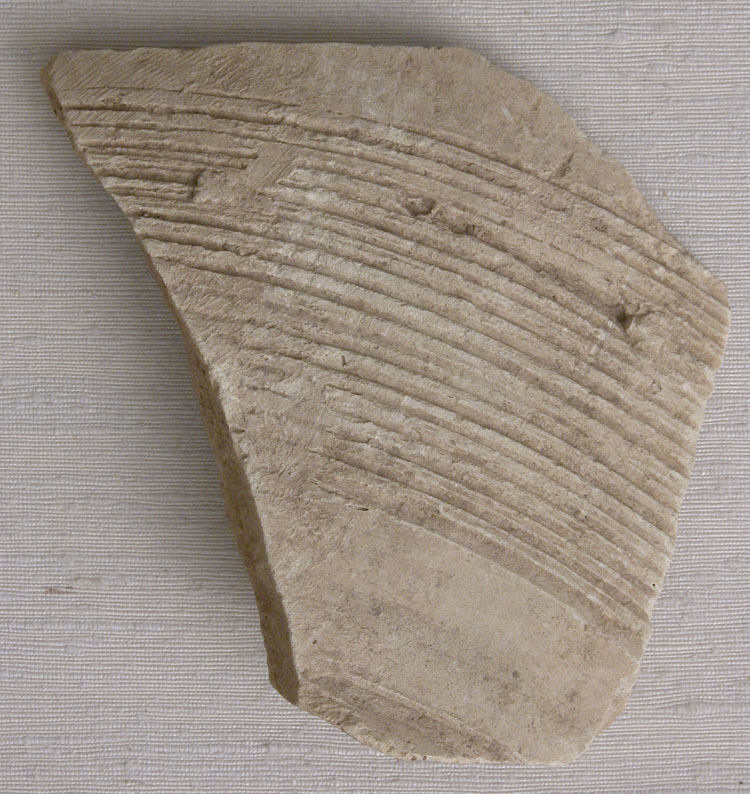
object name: fragment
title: Ceramic Fragment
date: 701-900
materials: earthenware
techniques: incising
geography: iraq